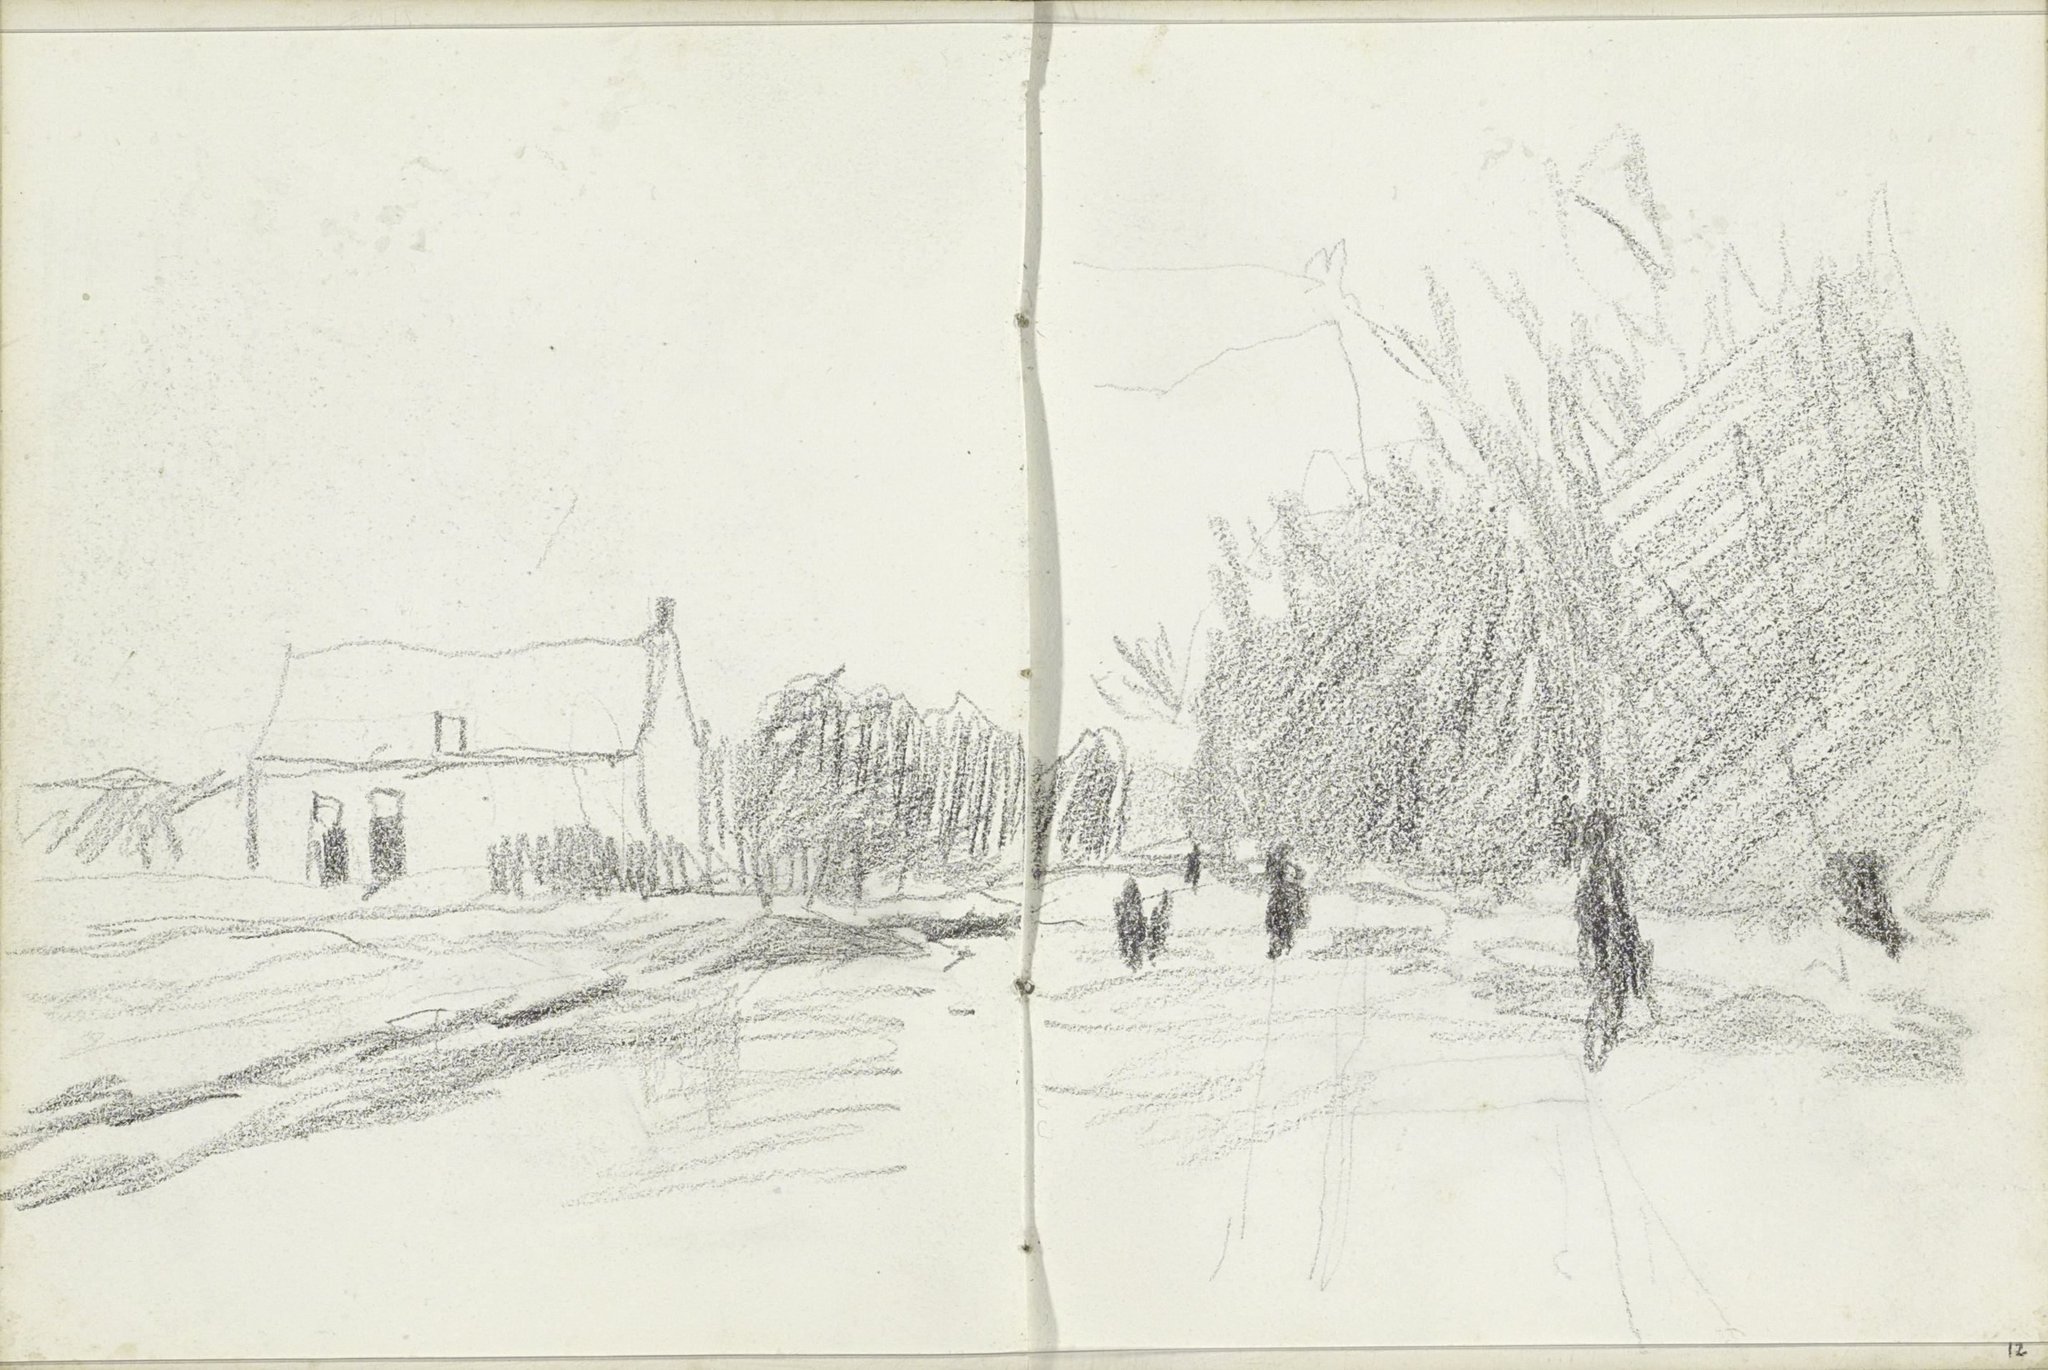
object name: sketchbook leaf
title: Landschap met figuren en een plattelandswoning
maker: johan hendrik weissenbruch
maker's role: draughtsman, painter, print maker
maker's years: 1824-1903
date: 1834-1903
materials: chalk, paper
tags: landscapes (+ landscape with figures, staffage), farm or solitary house in landscape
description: Blad 11 verso en 12 recto uit een schetsboek met 34 bladen.